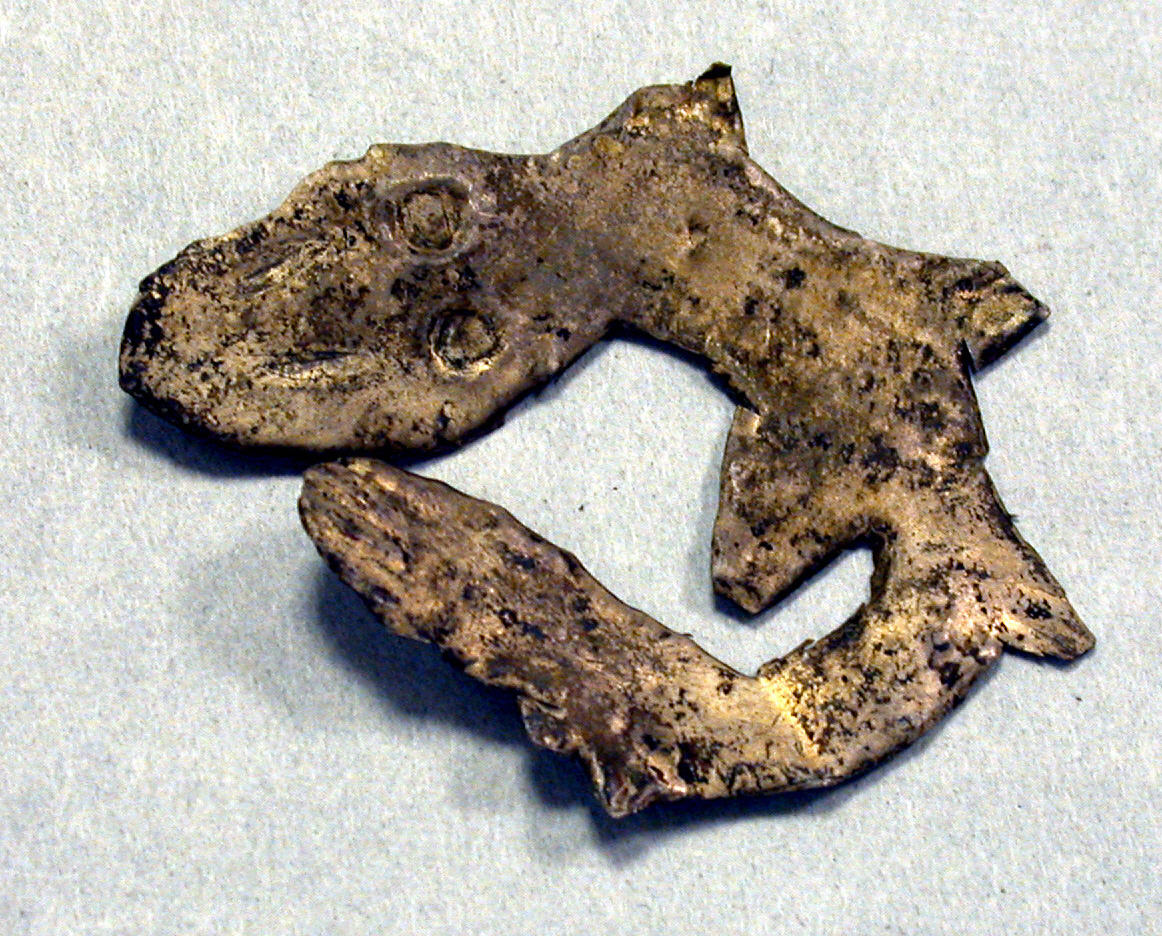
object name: ornament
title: Fish Ornament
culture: peruvian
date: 1001-1200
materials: silver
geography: peru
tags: fish